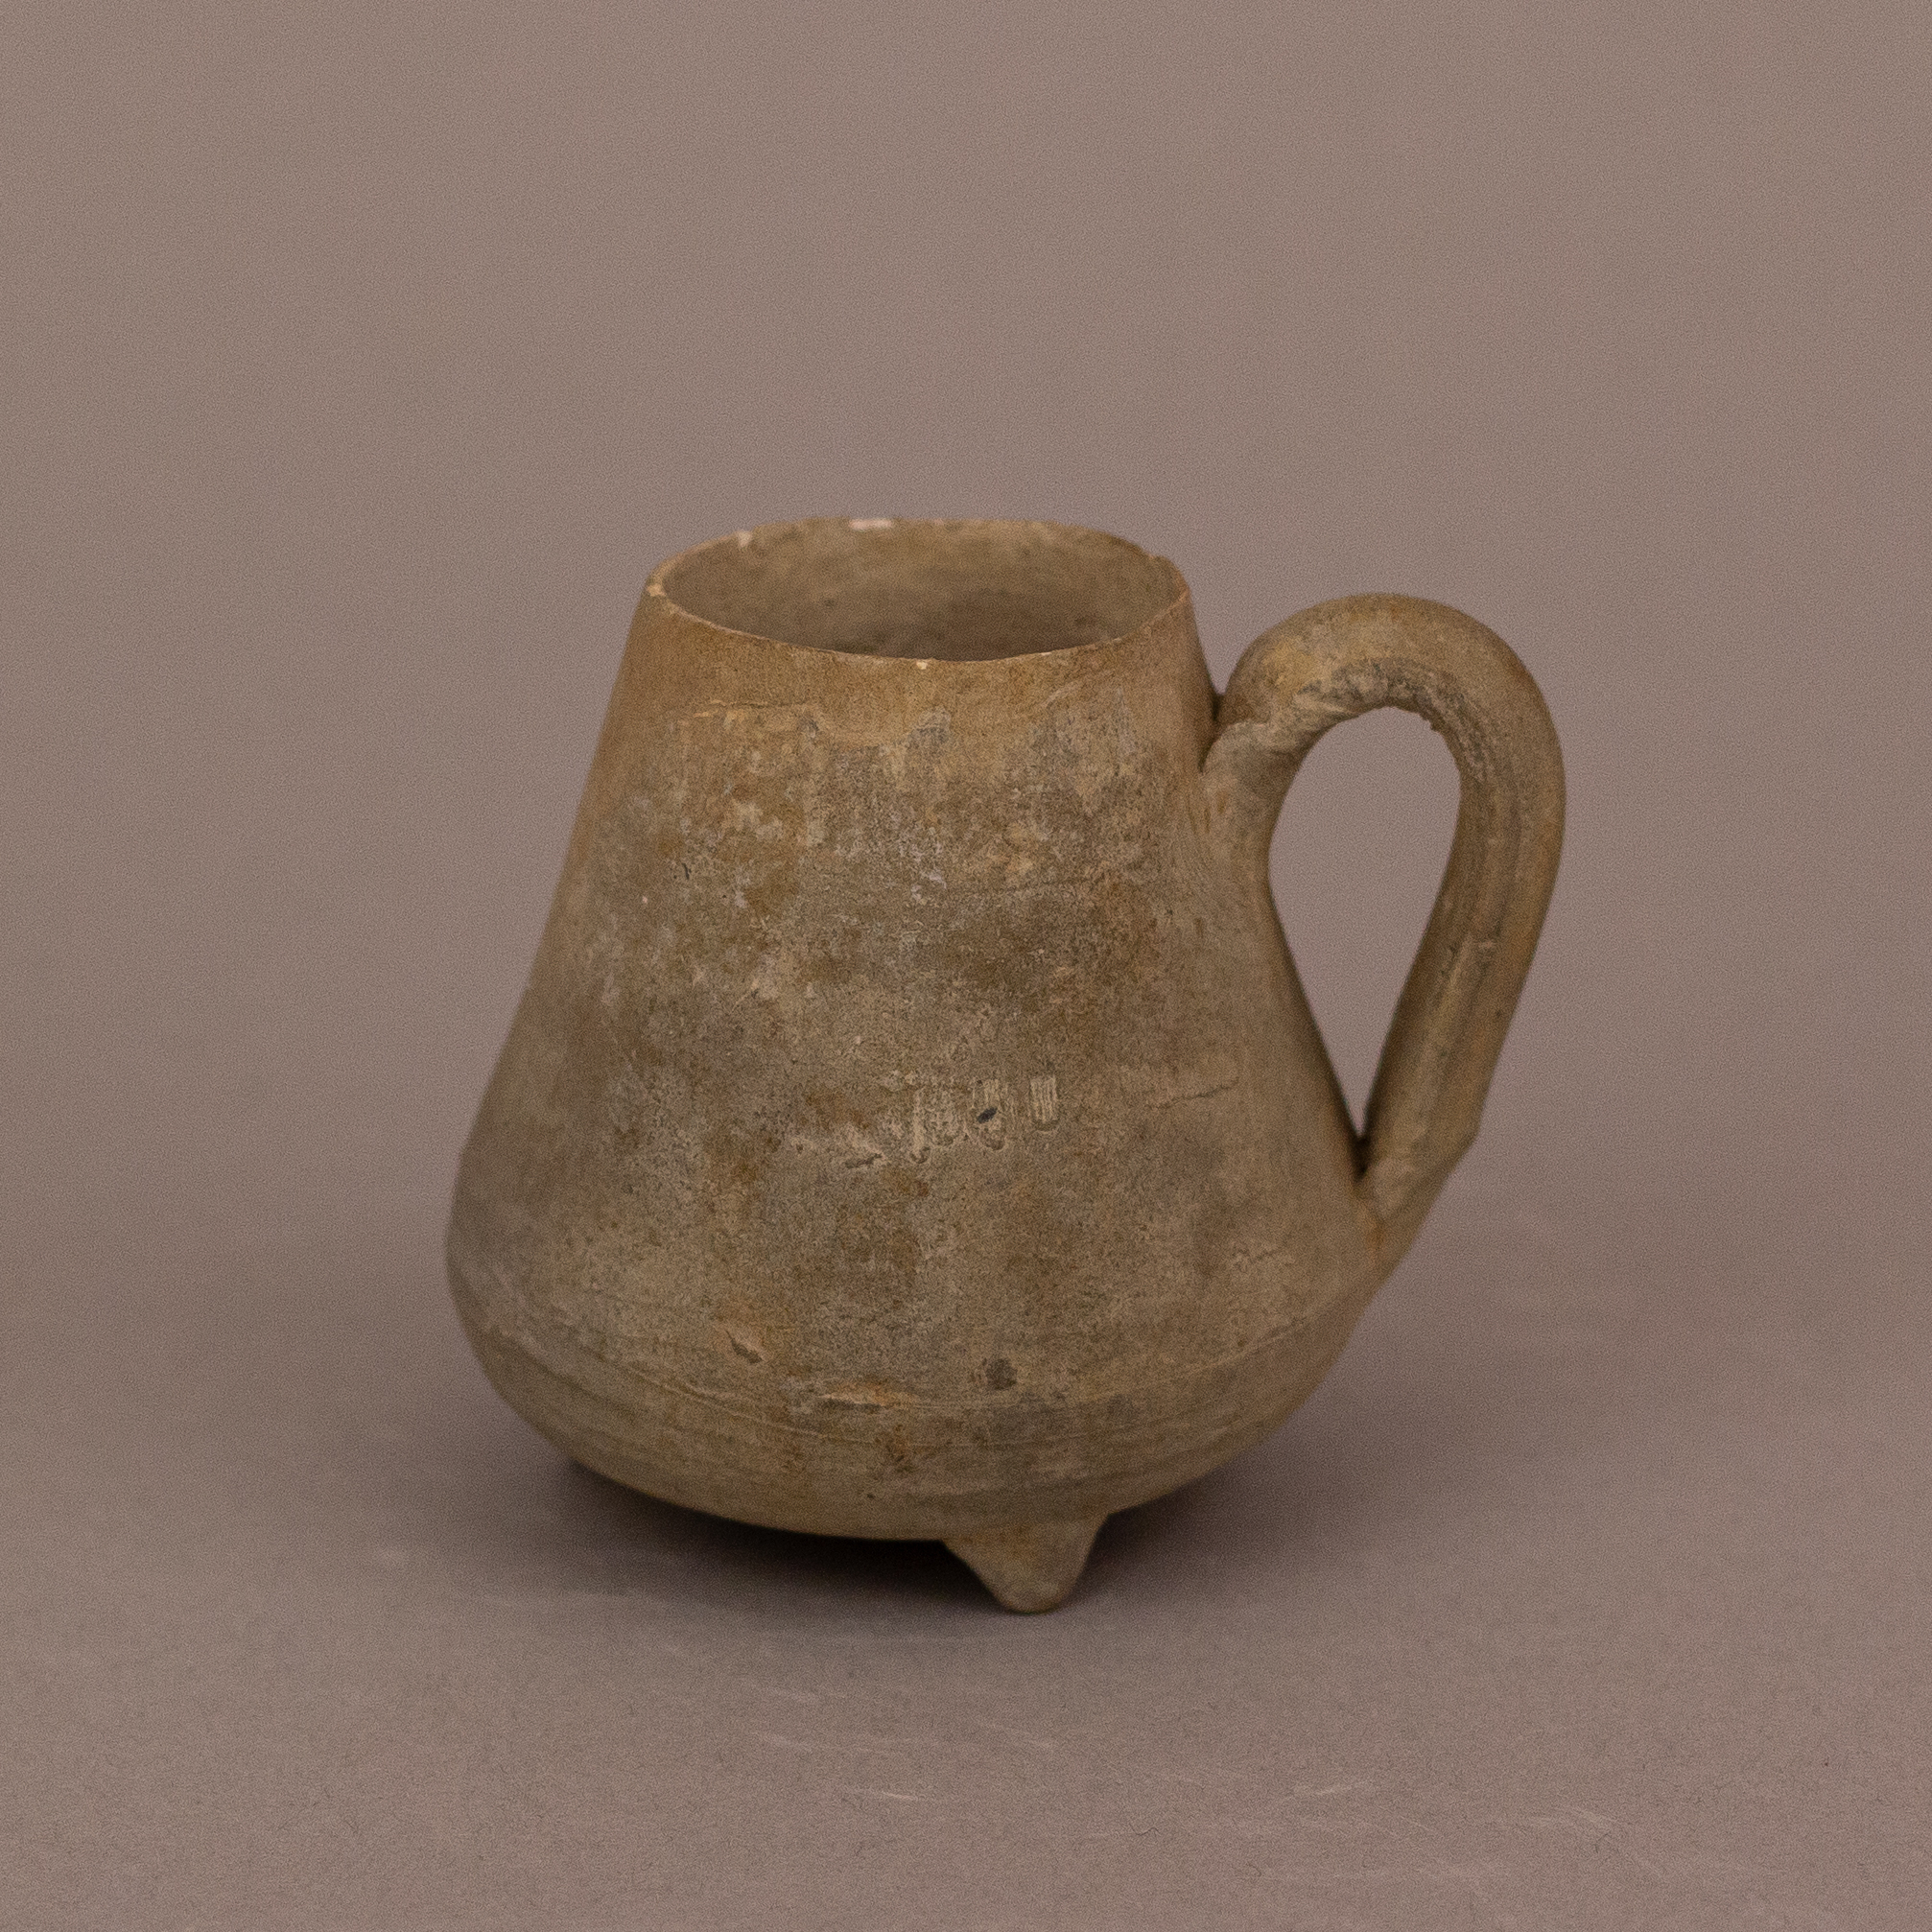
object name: cup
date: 801-1000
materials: earthenware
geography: iran